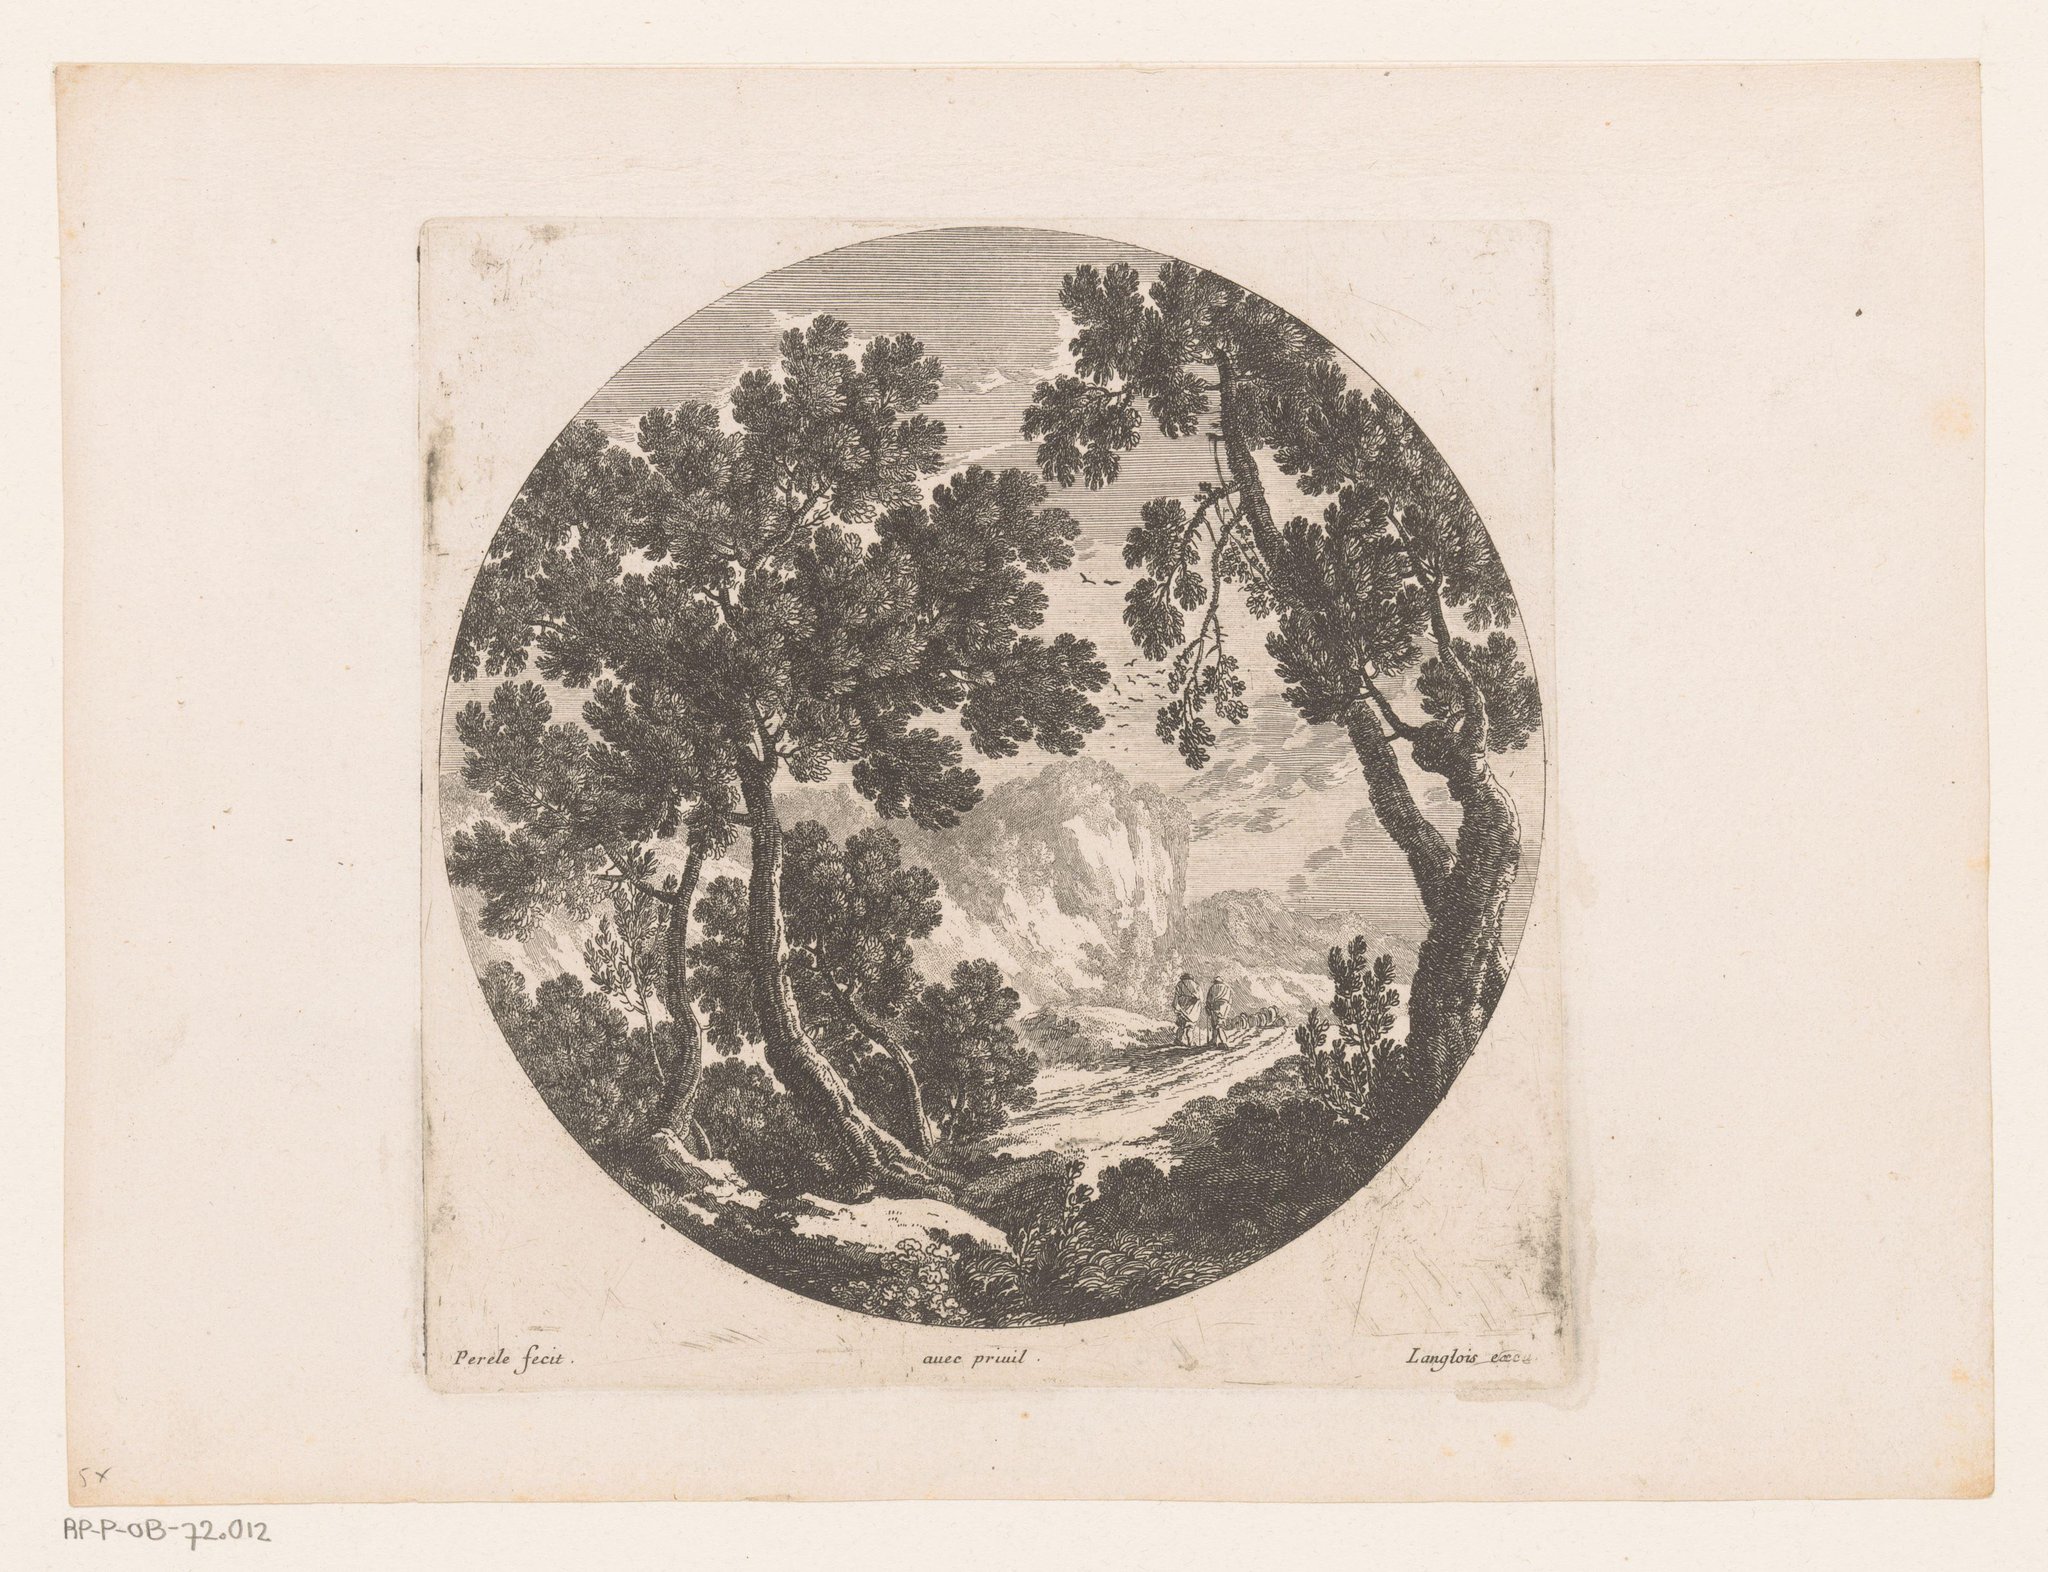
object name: print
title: Landschap met herders achter kudde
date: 1650-1695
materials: paper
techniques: etching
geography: paris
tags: forest path or lane, herd, flock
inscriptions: collector's mark: Lugt 240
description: Prenten met het signatuur 'Perelle' kunnen zowel door vader Gabriel als door zonen Nicolas en Adam gemaakt zijn.